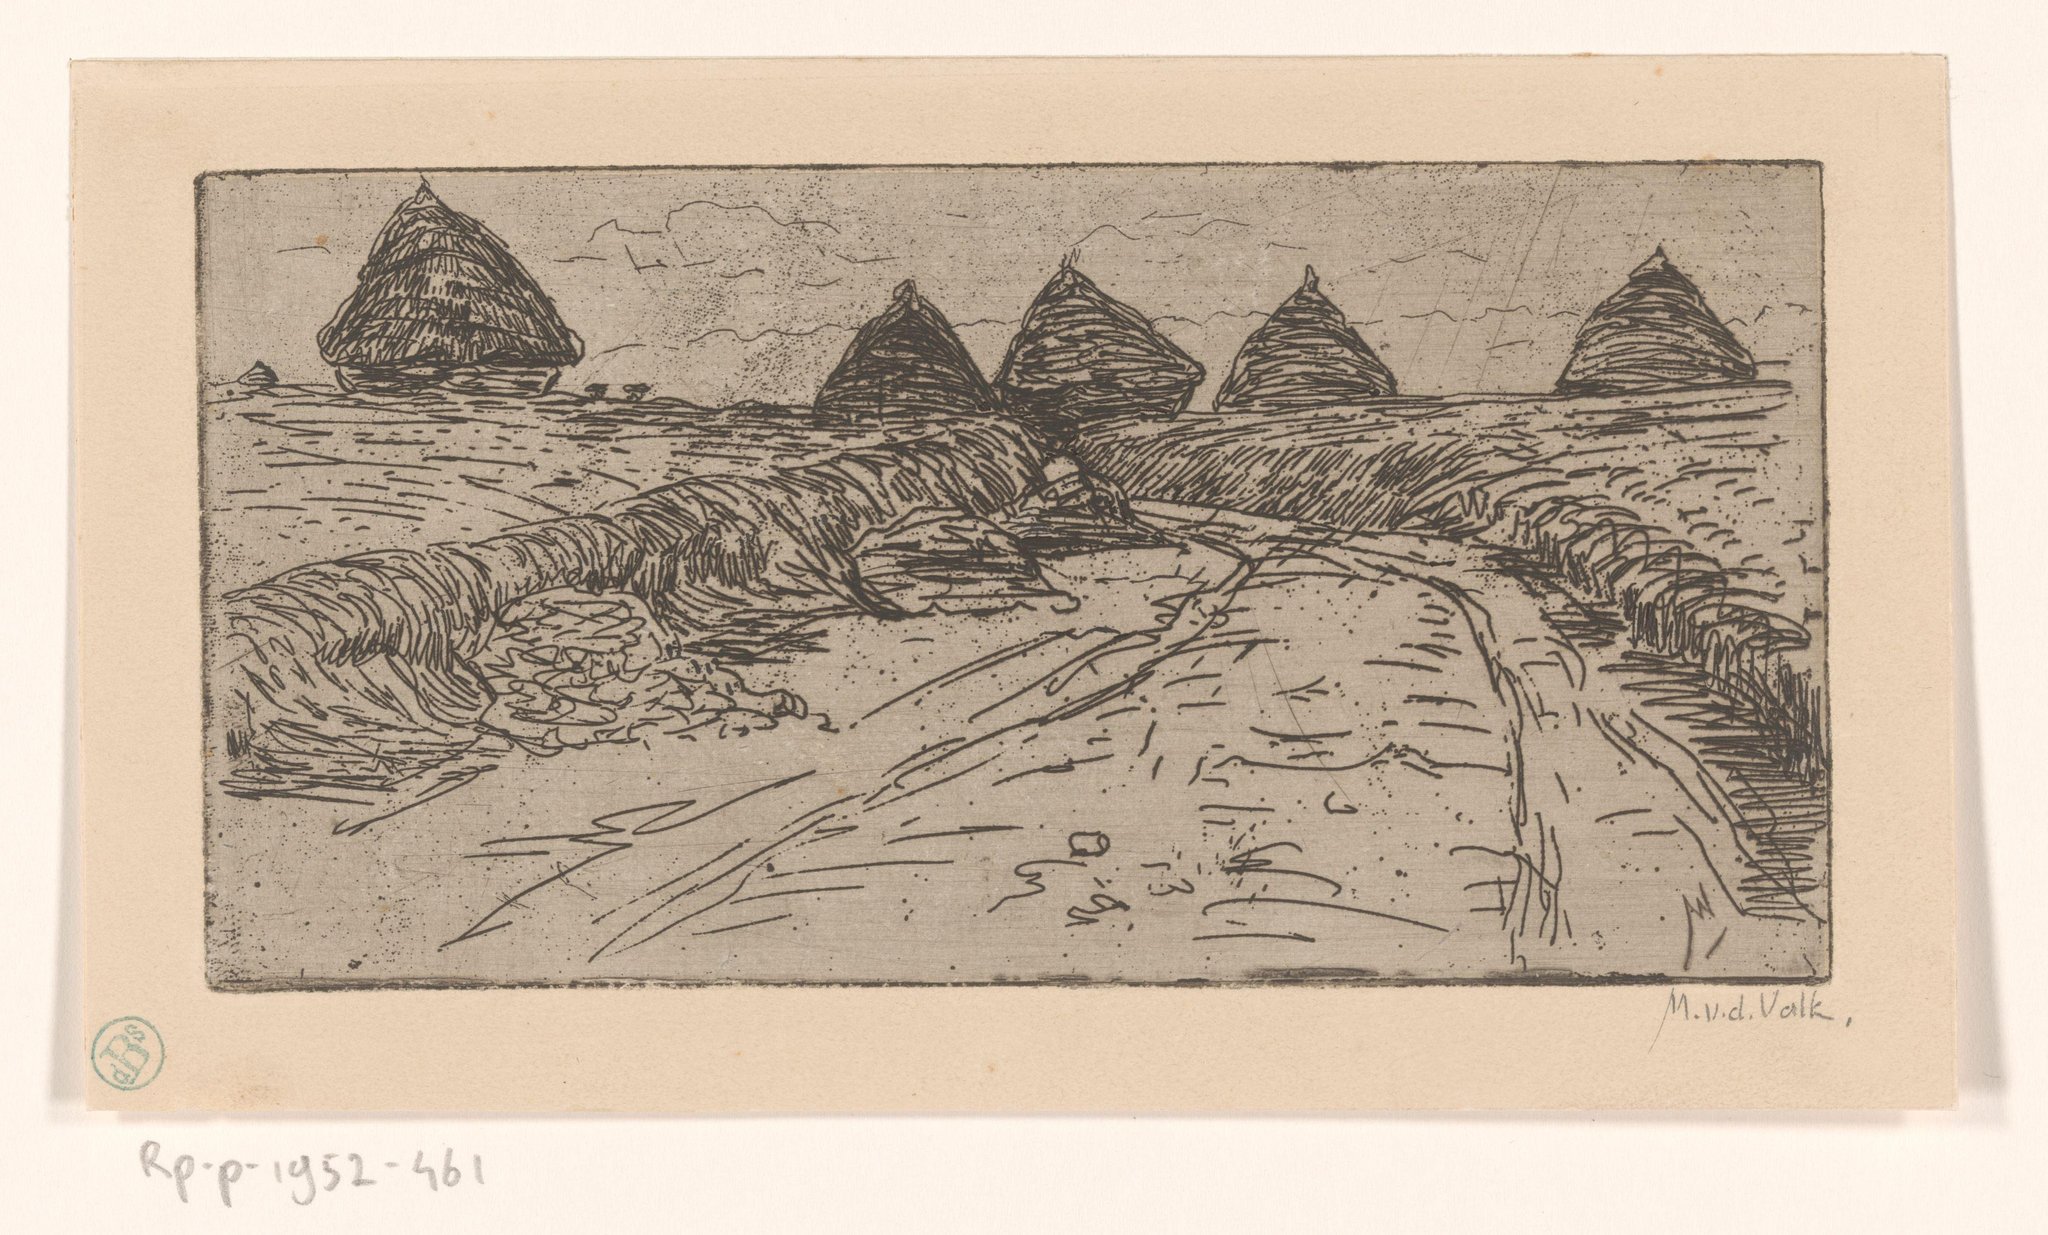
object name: print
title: Landweg door veld met hooioppers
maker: maurits van der valk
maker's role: draughtsman, print maker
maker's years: 1857-1935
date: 1867-1935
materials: paper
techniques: drypoint, etching, intaglio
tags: road, path, hay-cock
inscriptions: collector's mark: Lugt 733, collector's mark: Lugt 2228